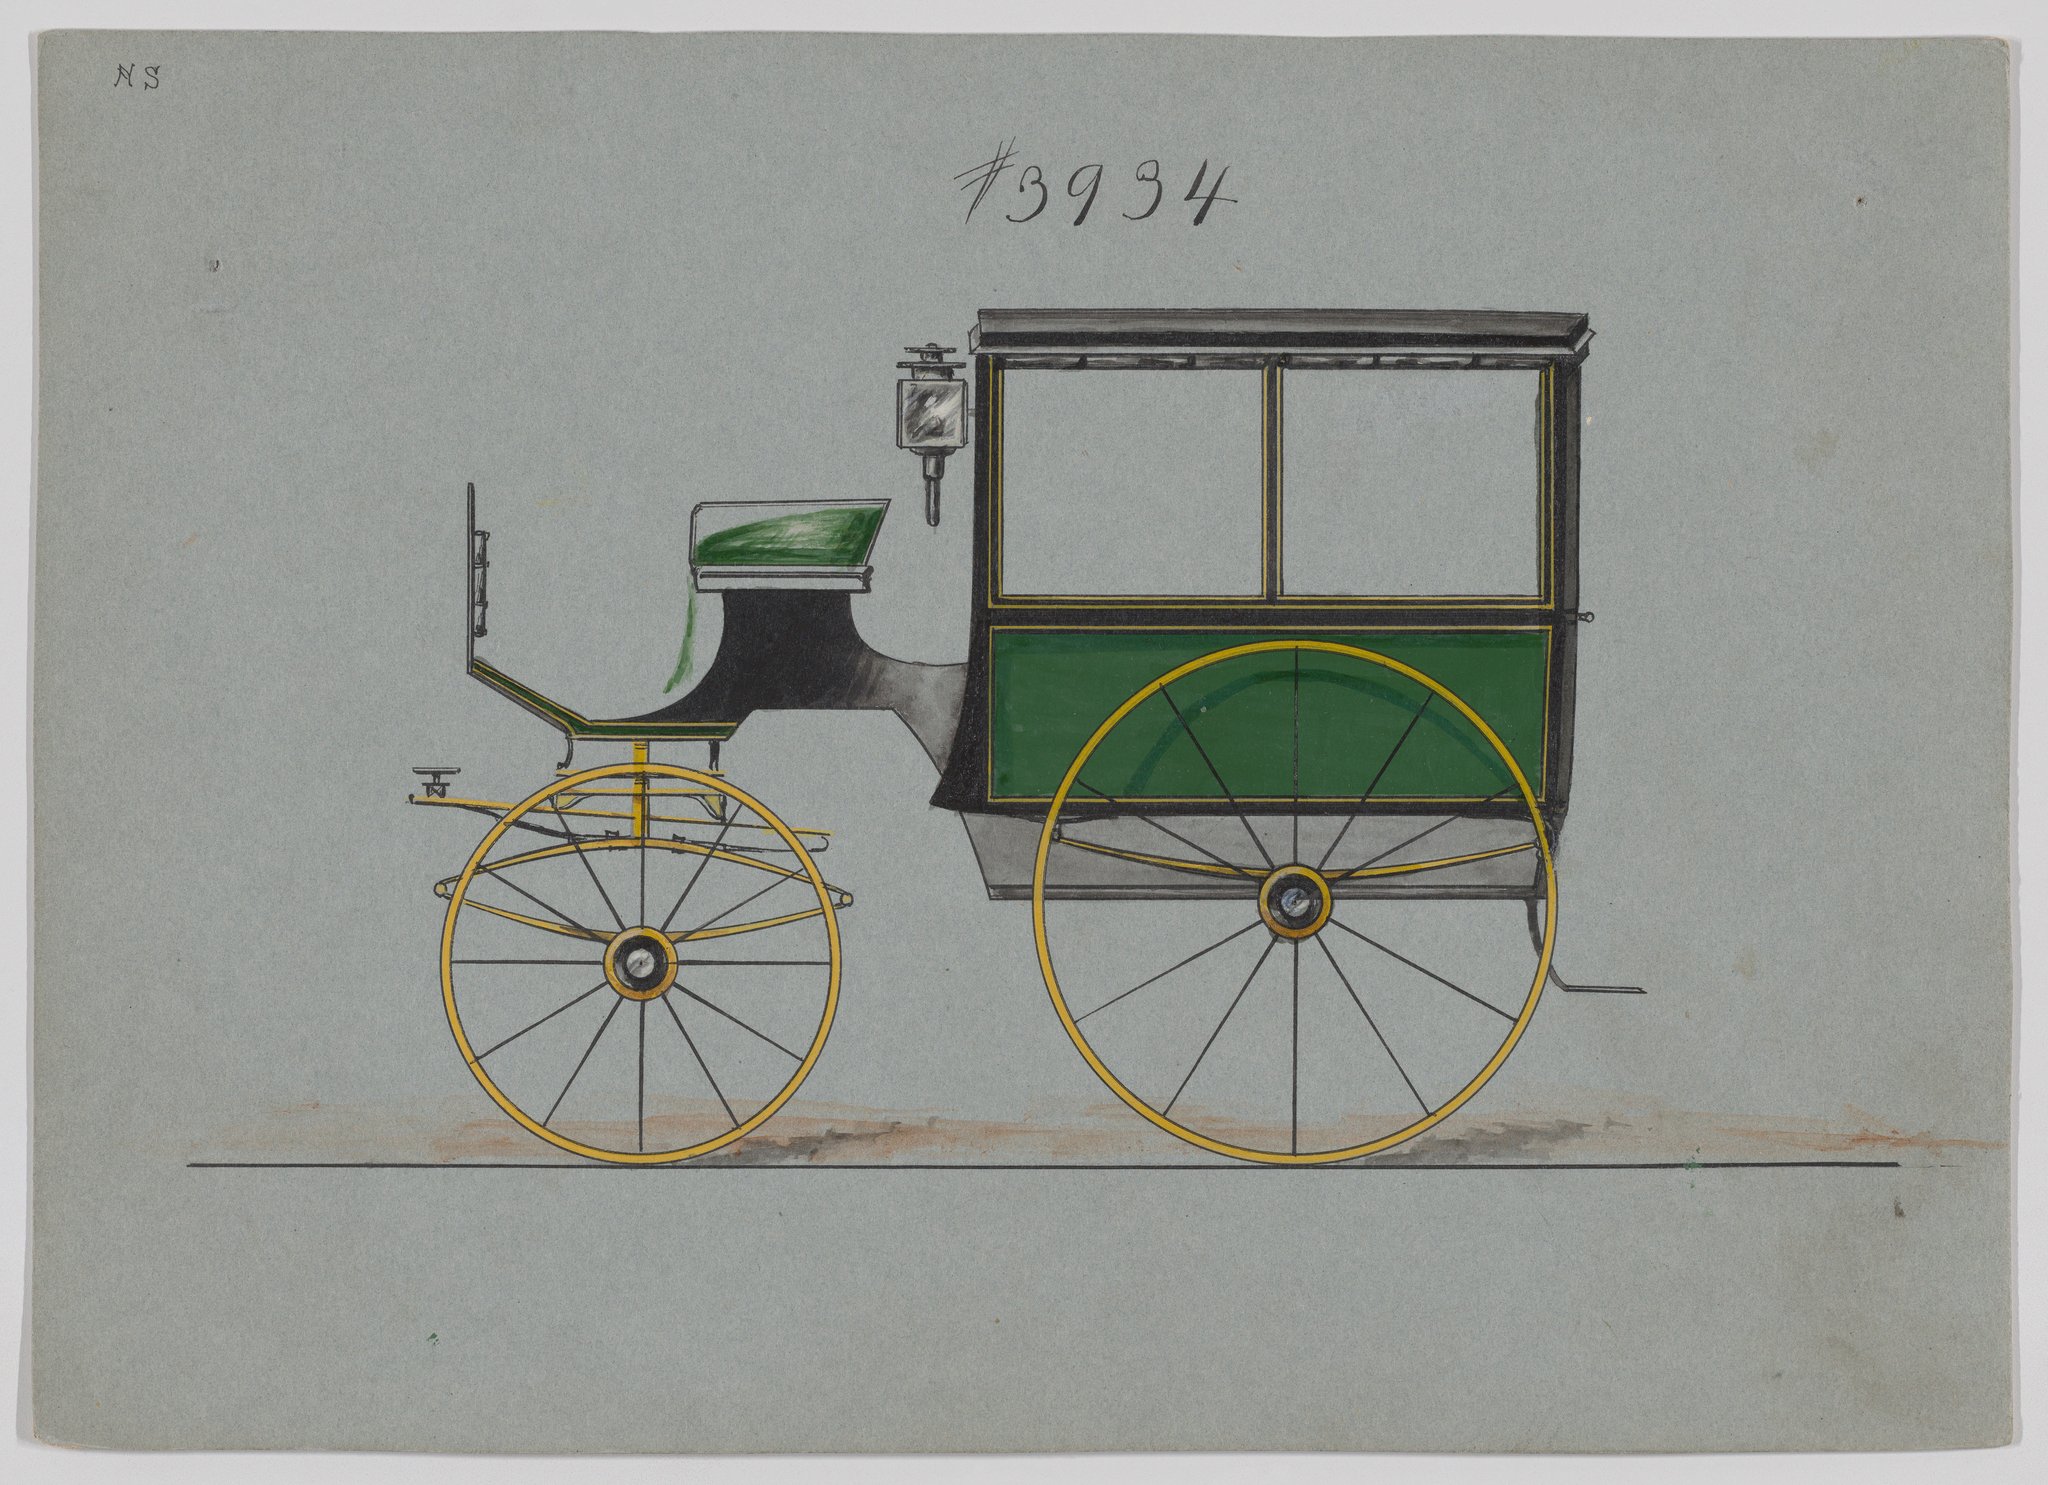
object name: drawing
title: Design for Omnibus or Wagonette, no. 3934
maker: brewster & co.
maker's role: manufacturer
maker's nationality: american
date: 1885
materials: gouache, gum arabic, ink, watercolor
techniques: pen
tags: carriages